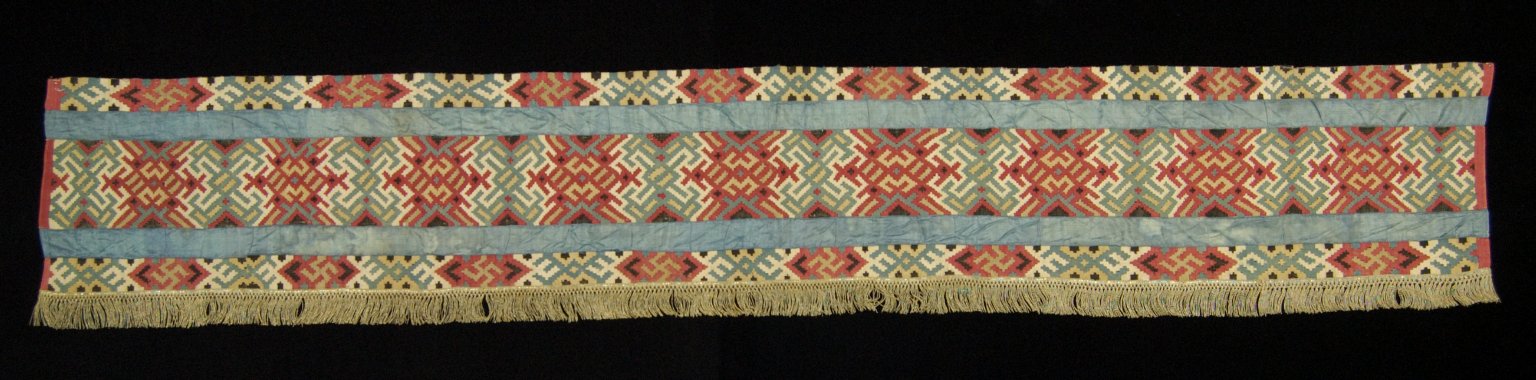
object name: textile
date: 1850-1899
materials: silk